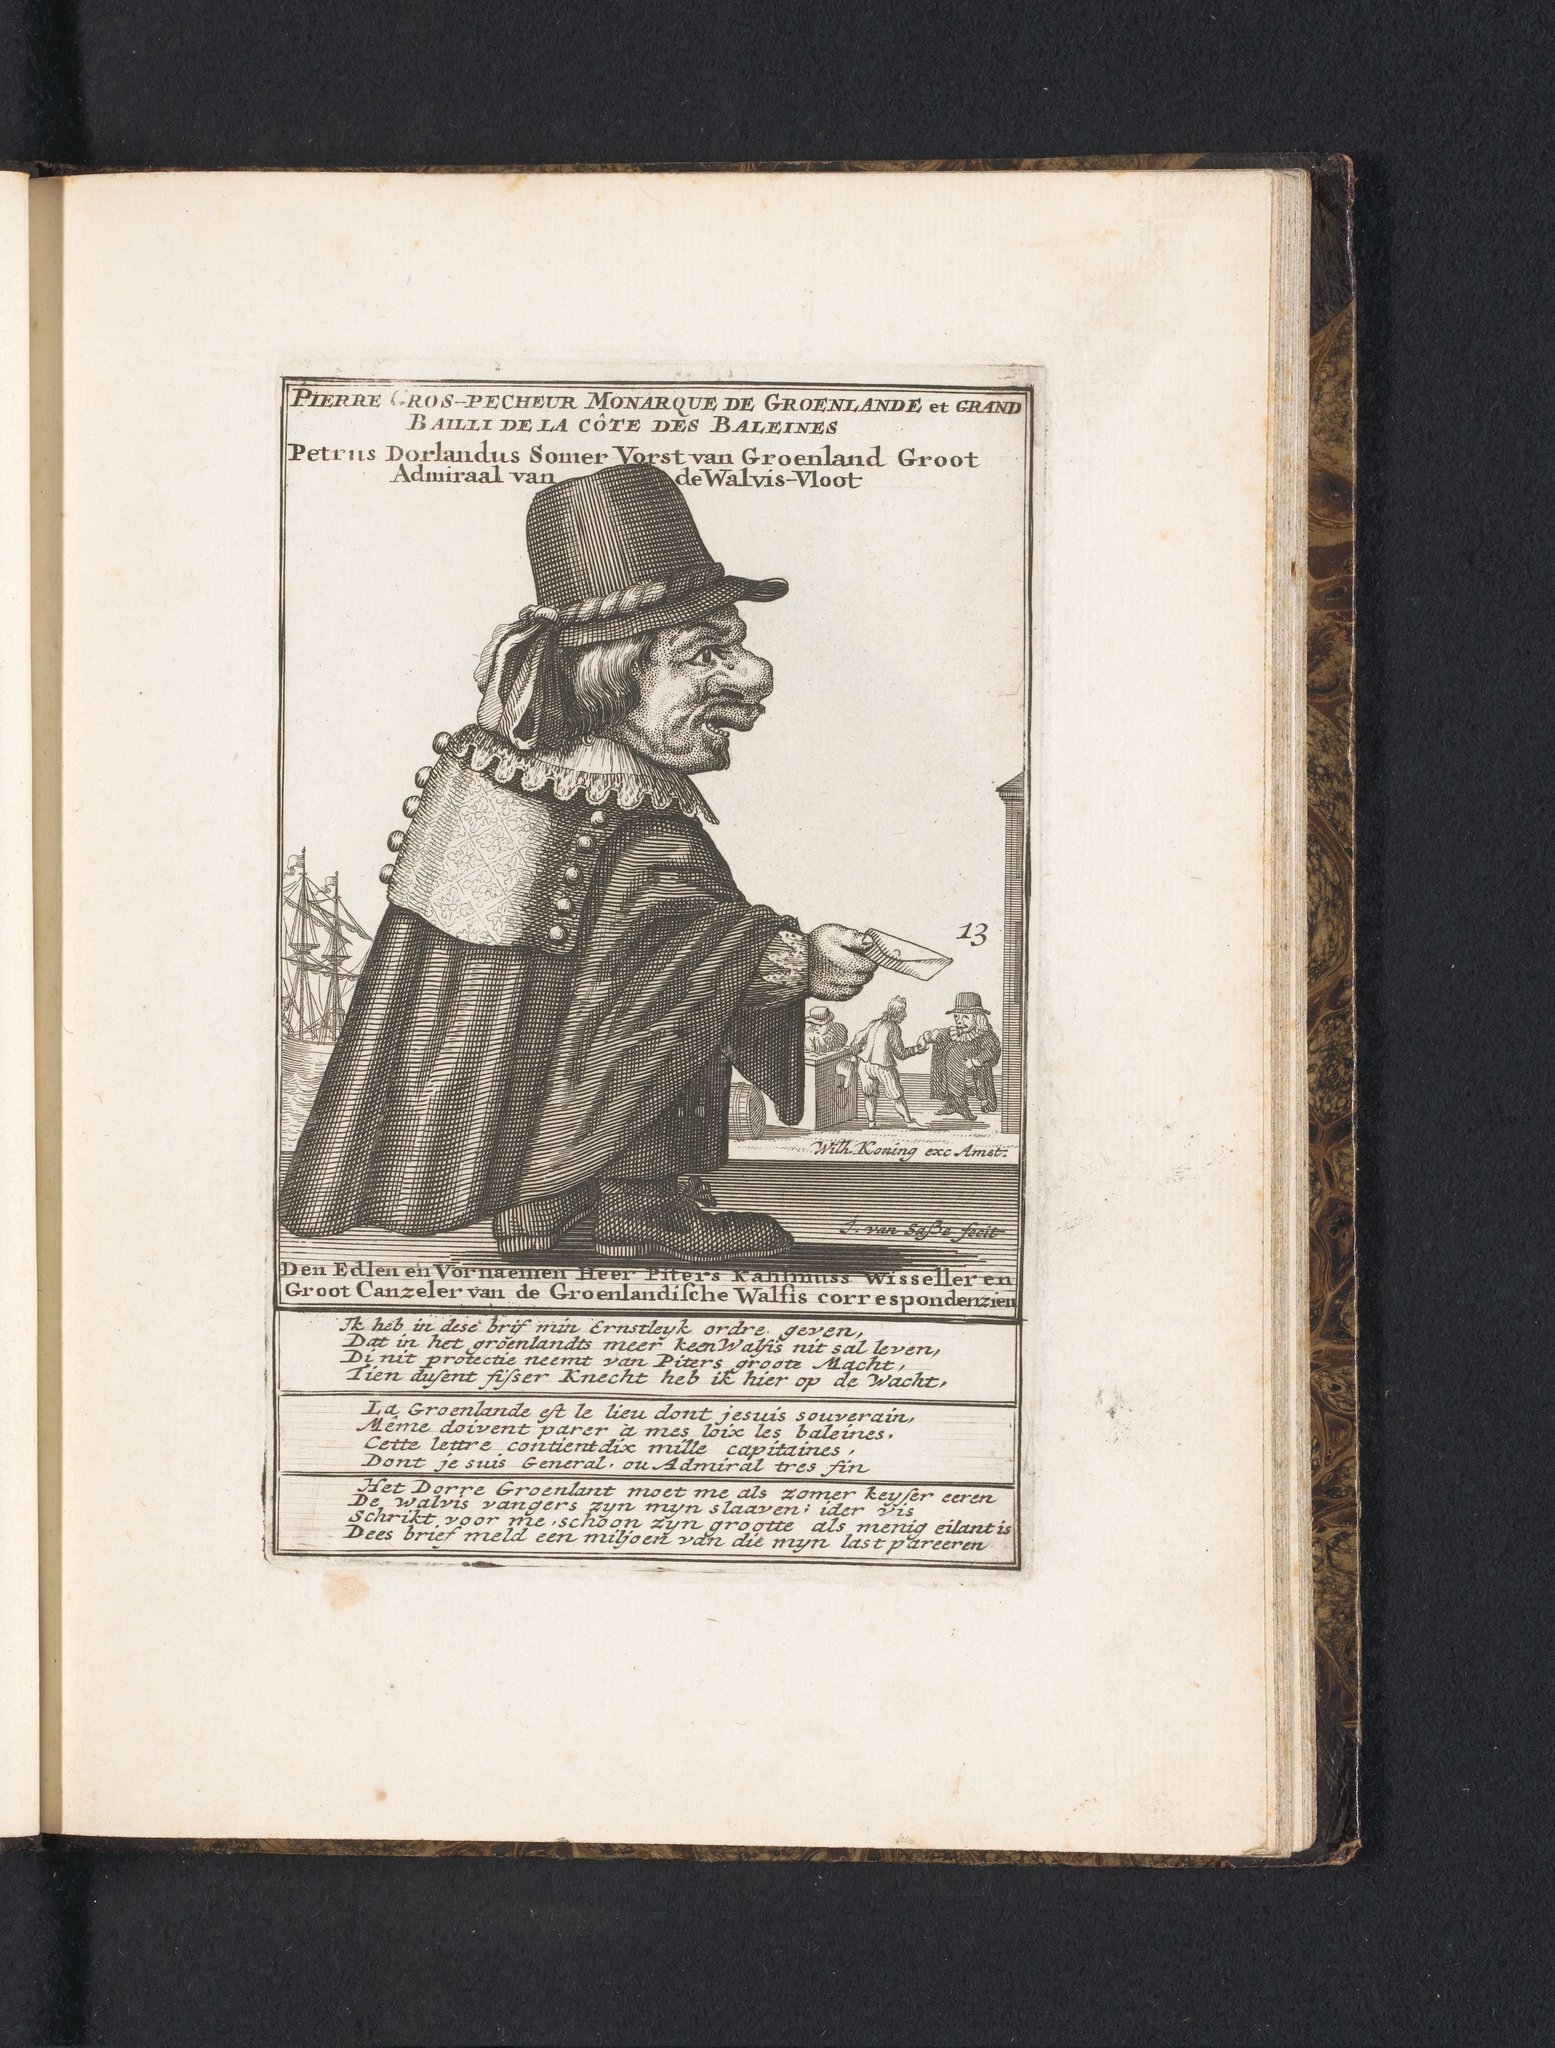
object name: print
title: De dwerg Petrus Dorlandus als walvisvaarder, 1720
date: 1718-1720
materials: paper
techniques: etching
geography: amsterdam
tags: caricatures (human types), little people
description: De kleine mens Petrus Dorlandus als (Nederlandse?) walvisvaarder in Groenland. In het onderschrift verzen in het Nederlands en Frans. Genummerd rechts midden: 13. Onderdeel van de tweede Nederlandse gebonden uitgave uit 1720 (en gerelateerd aan de Windhandel in dat jaar) van een serie karikaturen van kleine mensen, bekend als Het Dwergentooneel.